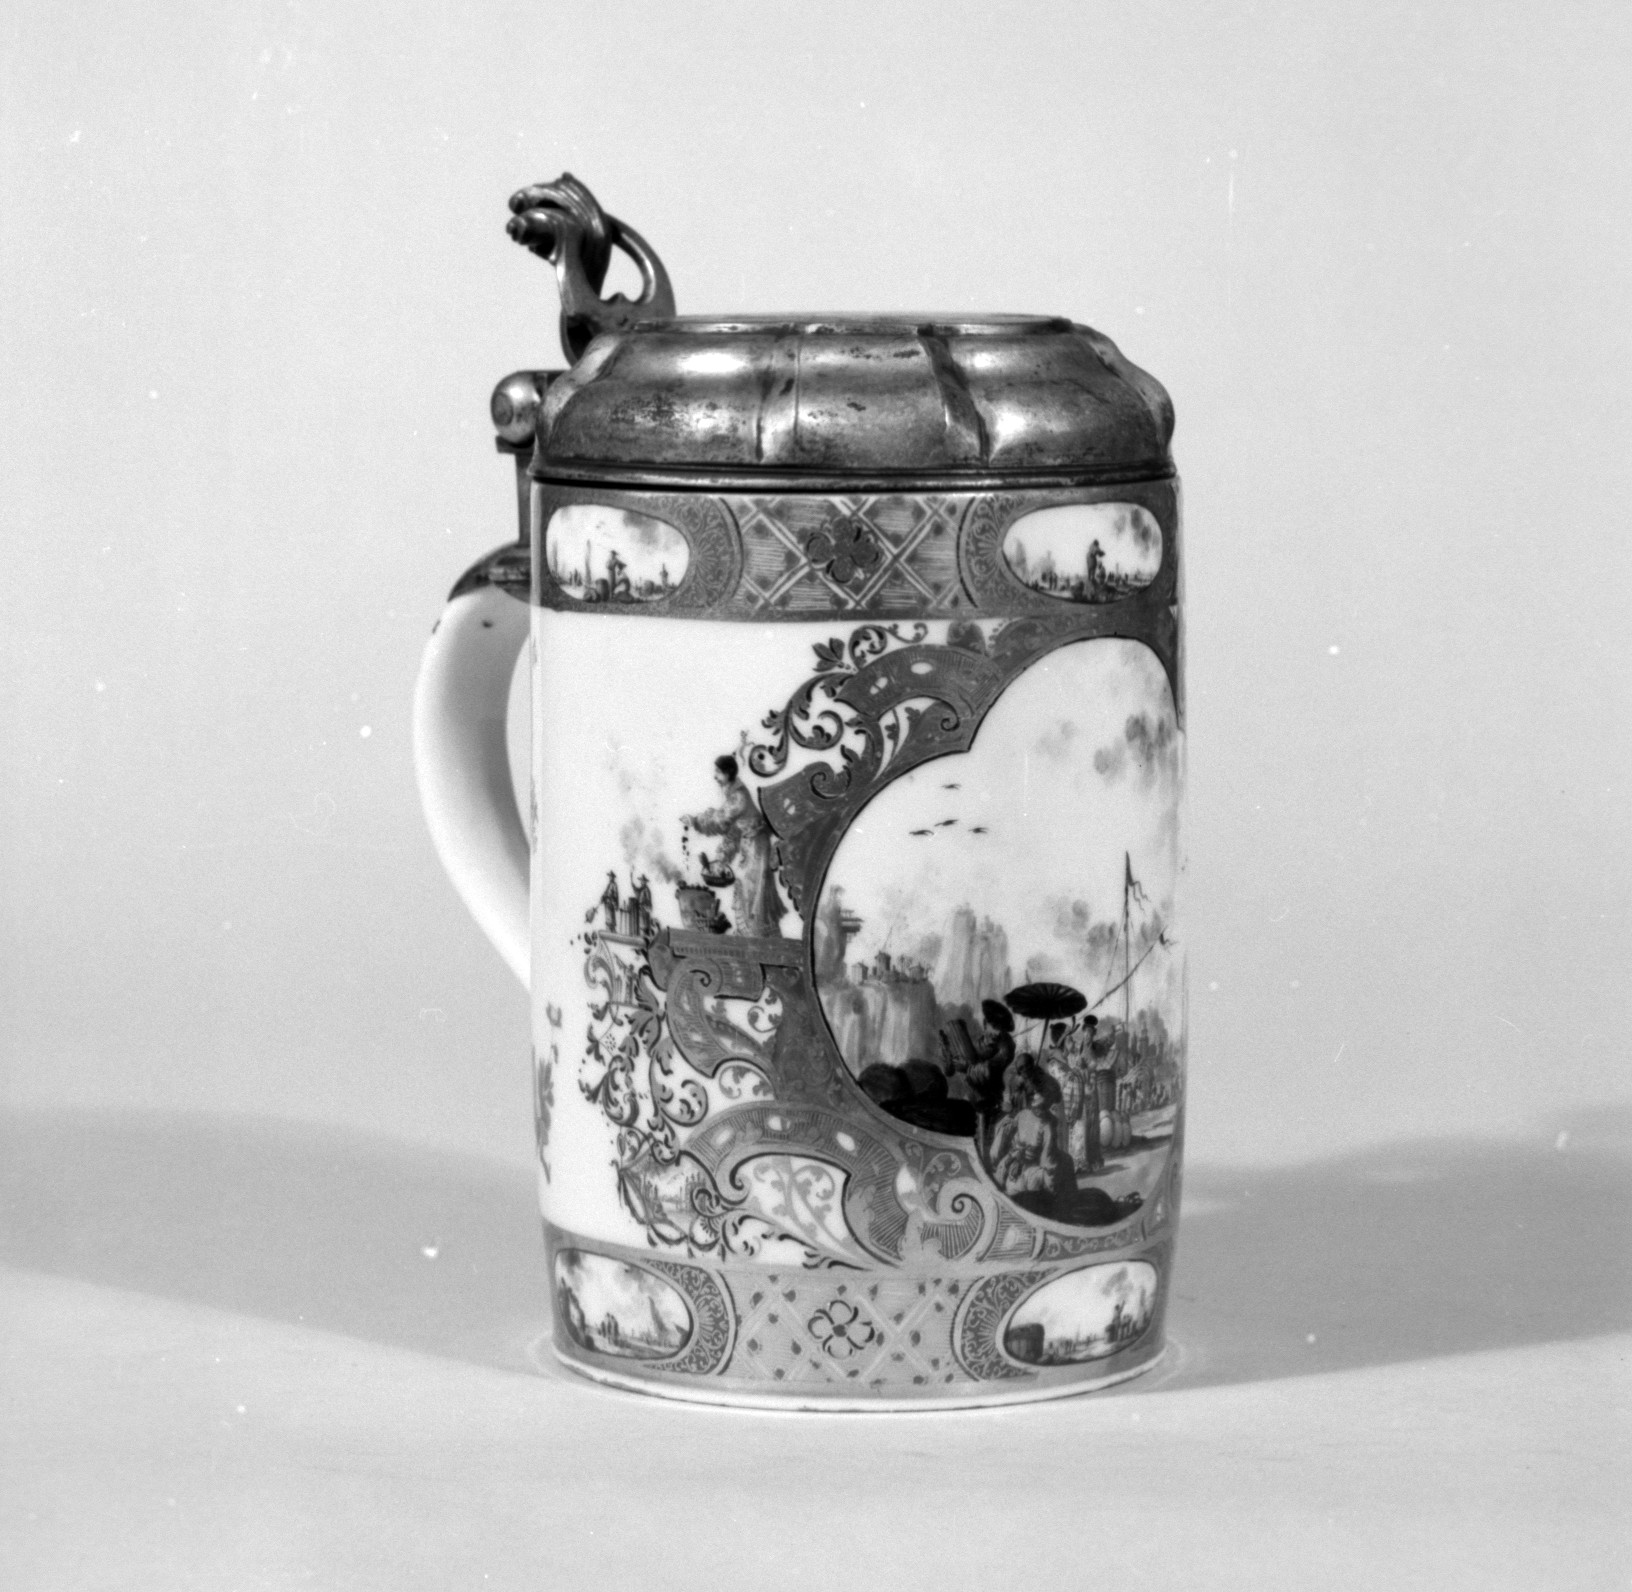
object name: tankard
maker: meissen manufactory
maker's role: manufactory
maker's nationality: german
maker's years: 1710-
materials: hard paste porcelain, silver gilt